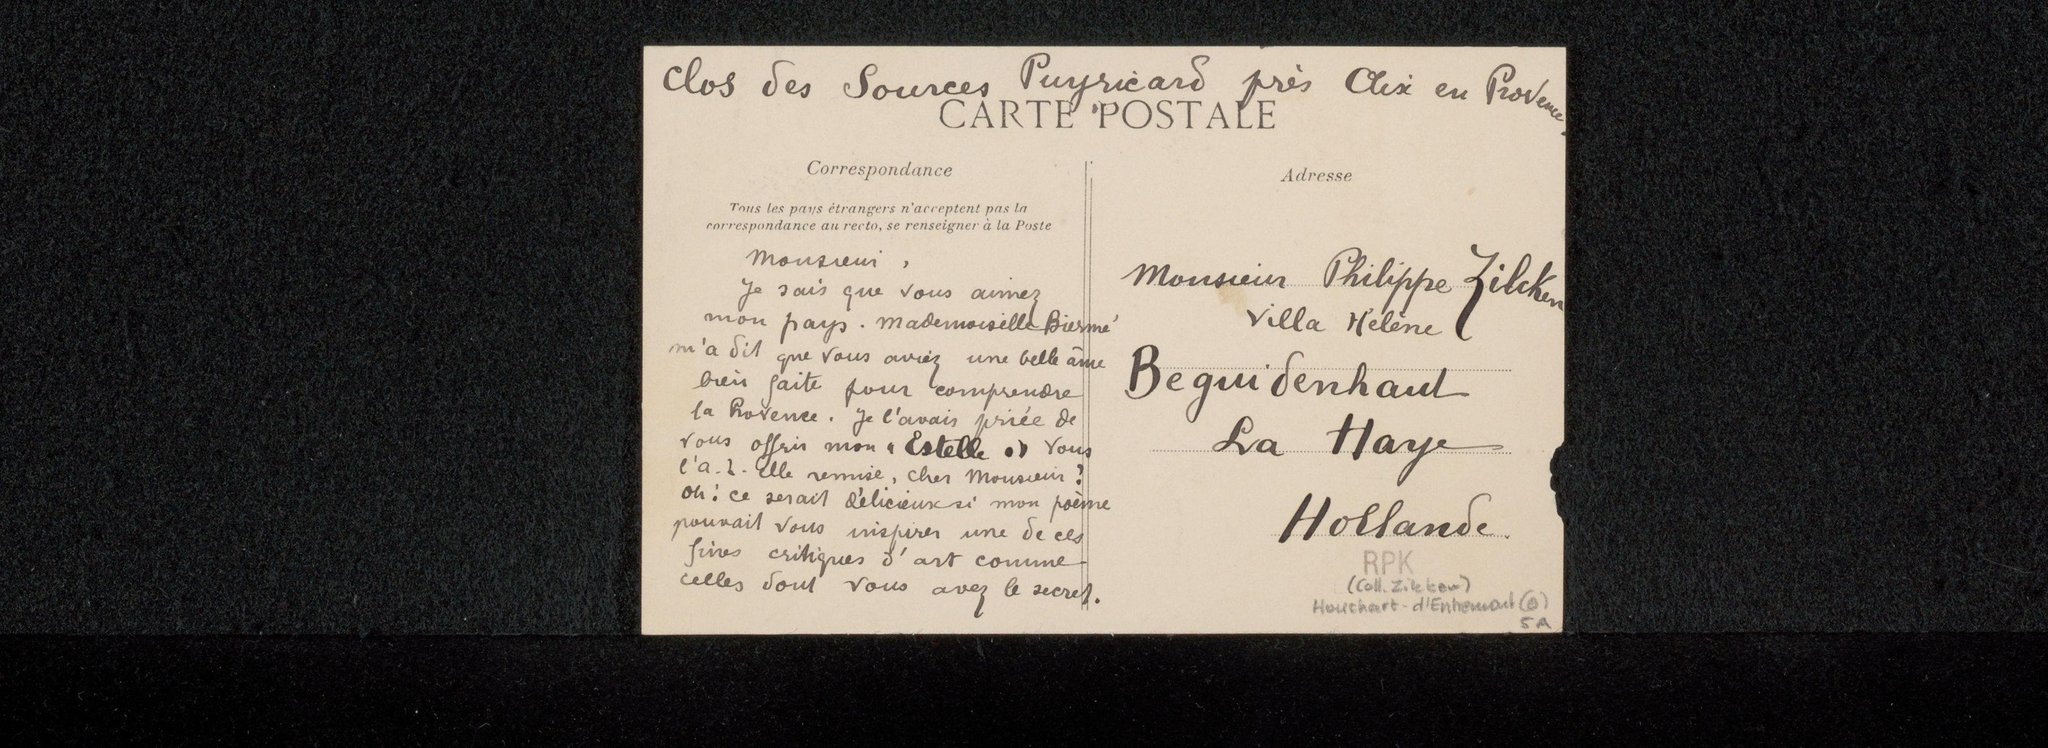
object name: ansichtkaart, prentbriefkaart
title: Prentbriefkaart aan Philip Zilcken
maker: eugénie clapier-houchart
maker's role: dichter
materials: cardboard, ink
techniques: photograph, pen, writing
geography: puyricard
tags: maria biermé, the hague, painter, draughtsman, philip zilcken, literature ~ arts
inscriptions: collector's mark: ‘RPK’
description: Prentbriefkaart is samen met RP-D-1982-43-HOUCHARTDENTREMONT(G.)-5B verstuurd in één envelop.